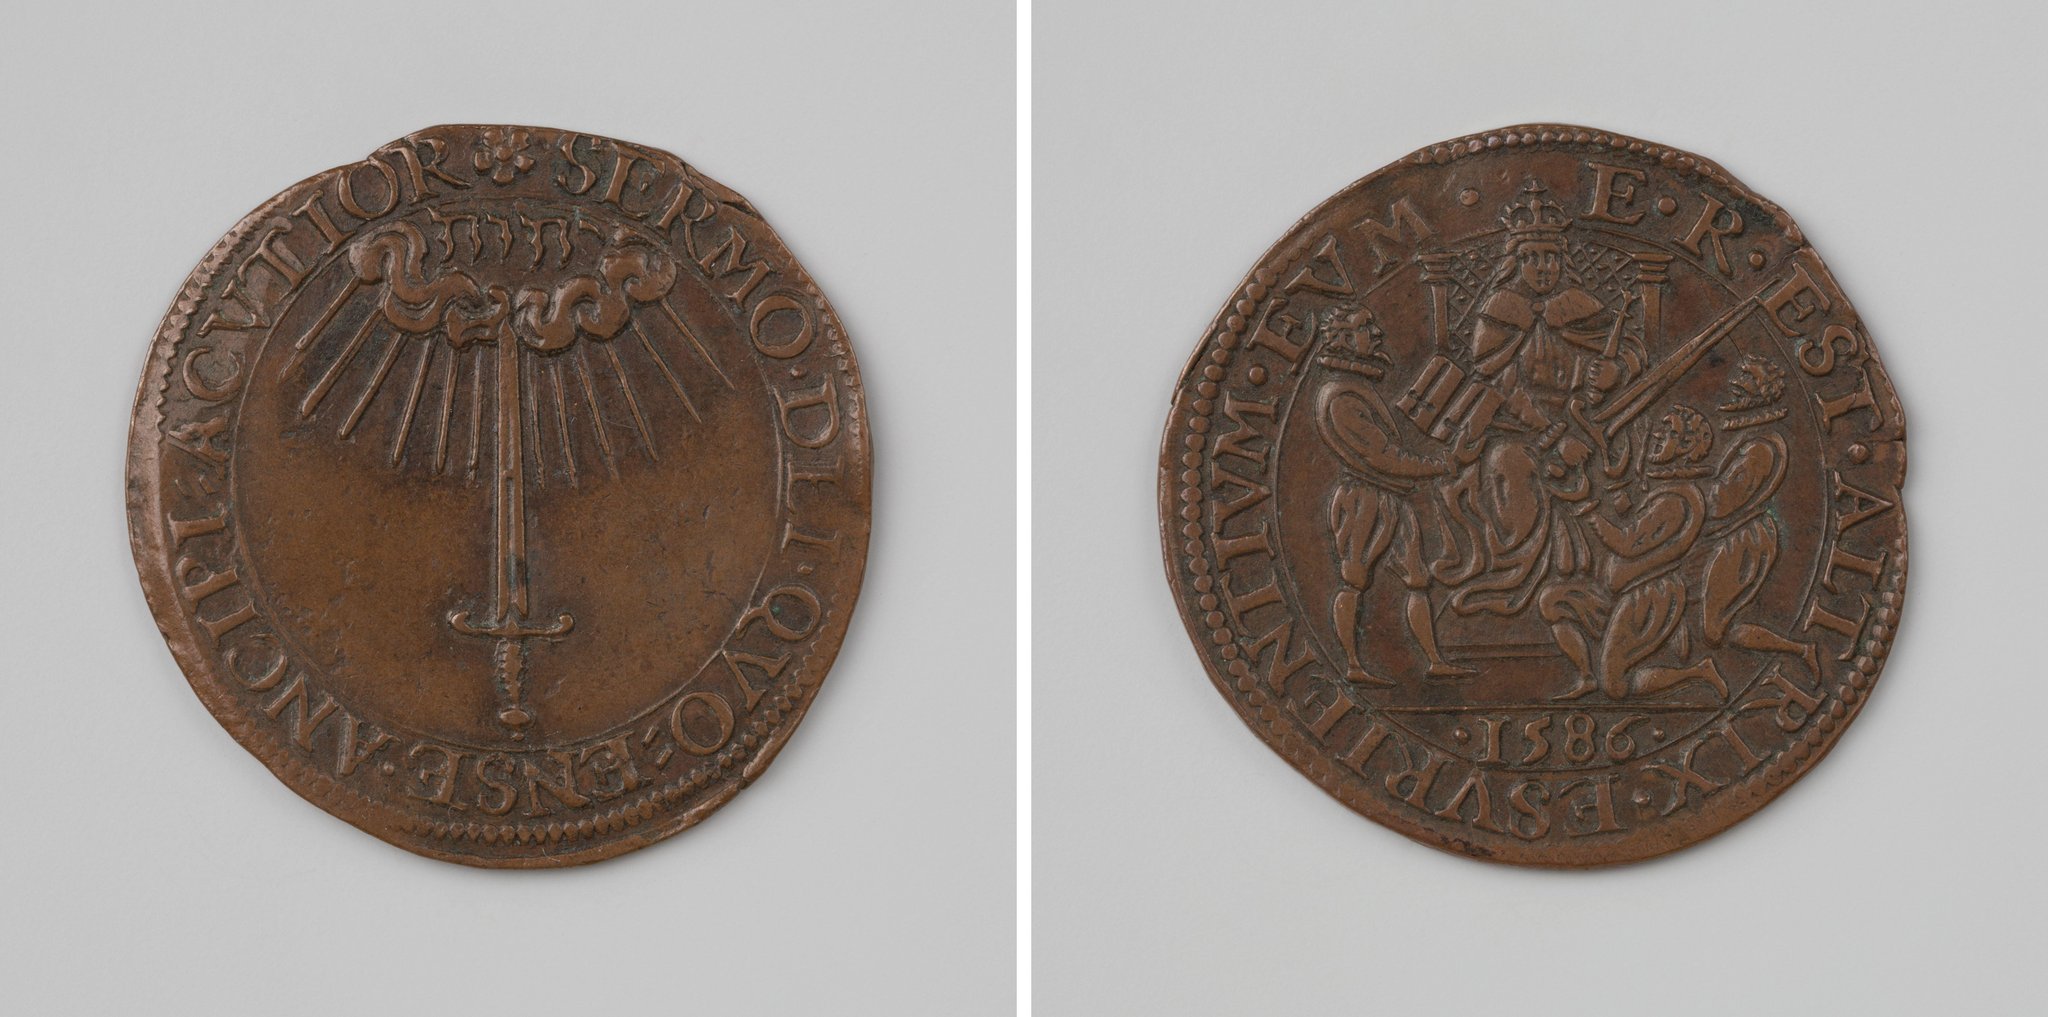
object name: jeton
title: Engelse hulp aan de opstandelingen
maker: Anonymous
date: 1586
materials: copper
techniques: striking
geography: dordrecht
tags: greenwich, richmond (surrey), koningin, elizabeth i tudor (koningin van engeland), tachtigjarige oorlog